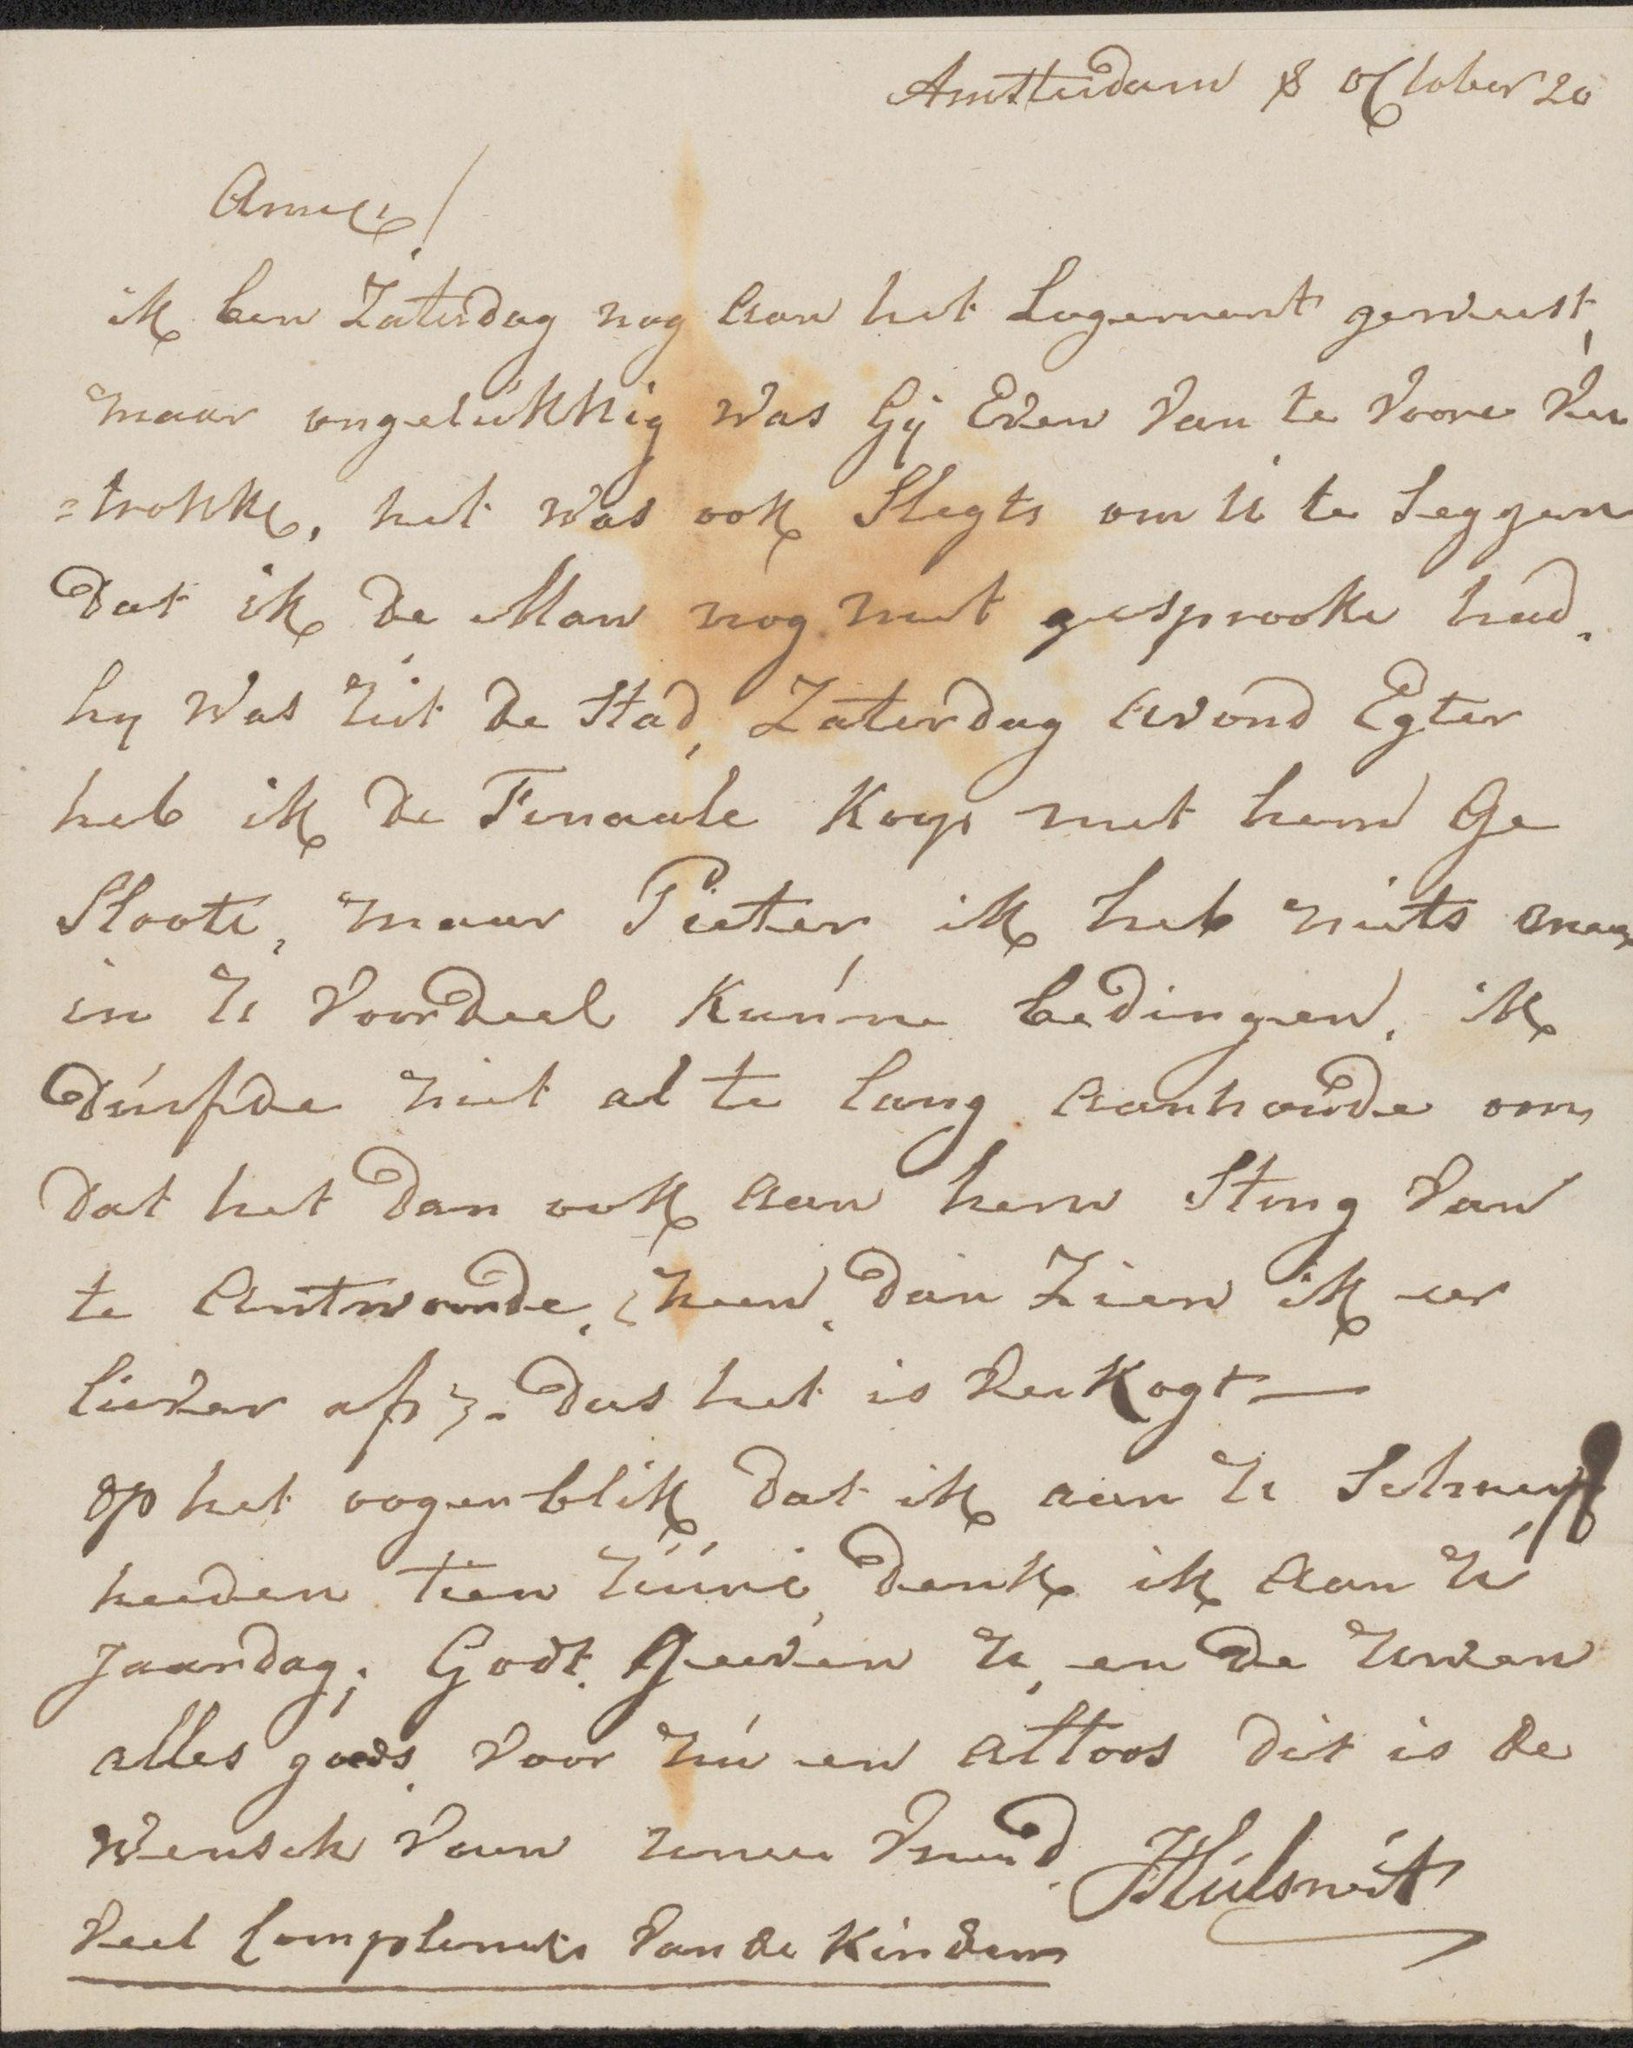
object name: letter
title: Brief aan Pieter Gerardus van Os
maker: jan hulswit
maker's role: draughtsman, painter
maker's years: 1766-1822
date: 1820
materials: ink, paper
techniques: pen, writing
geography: amsterdam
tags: the hague, print maker, pieter gerardus van os, money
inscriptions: watermark